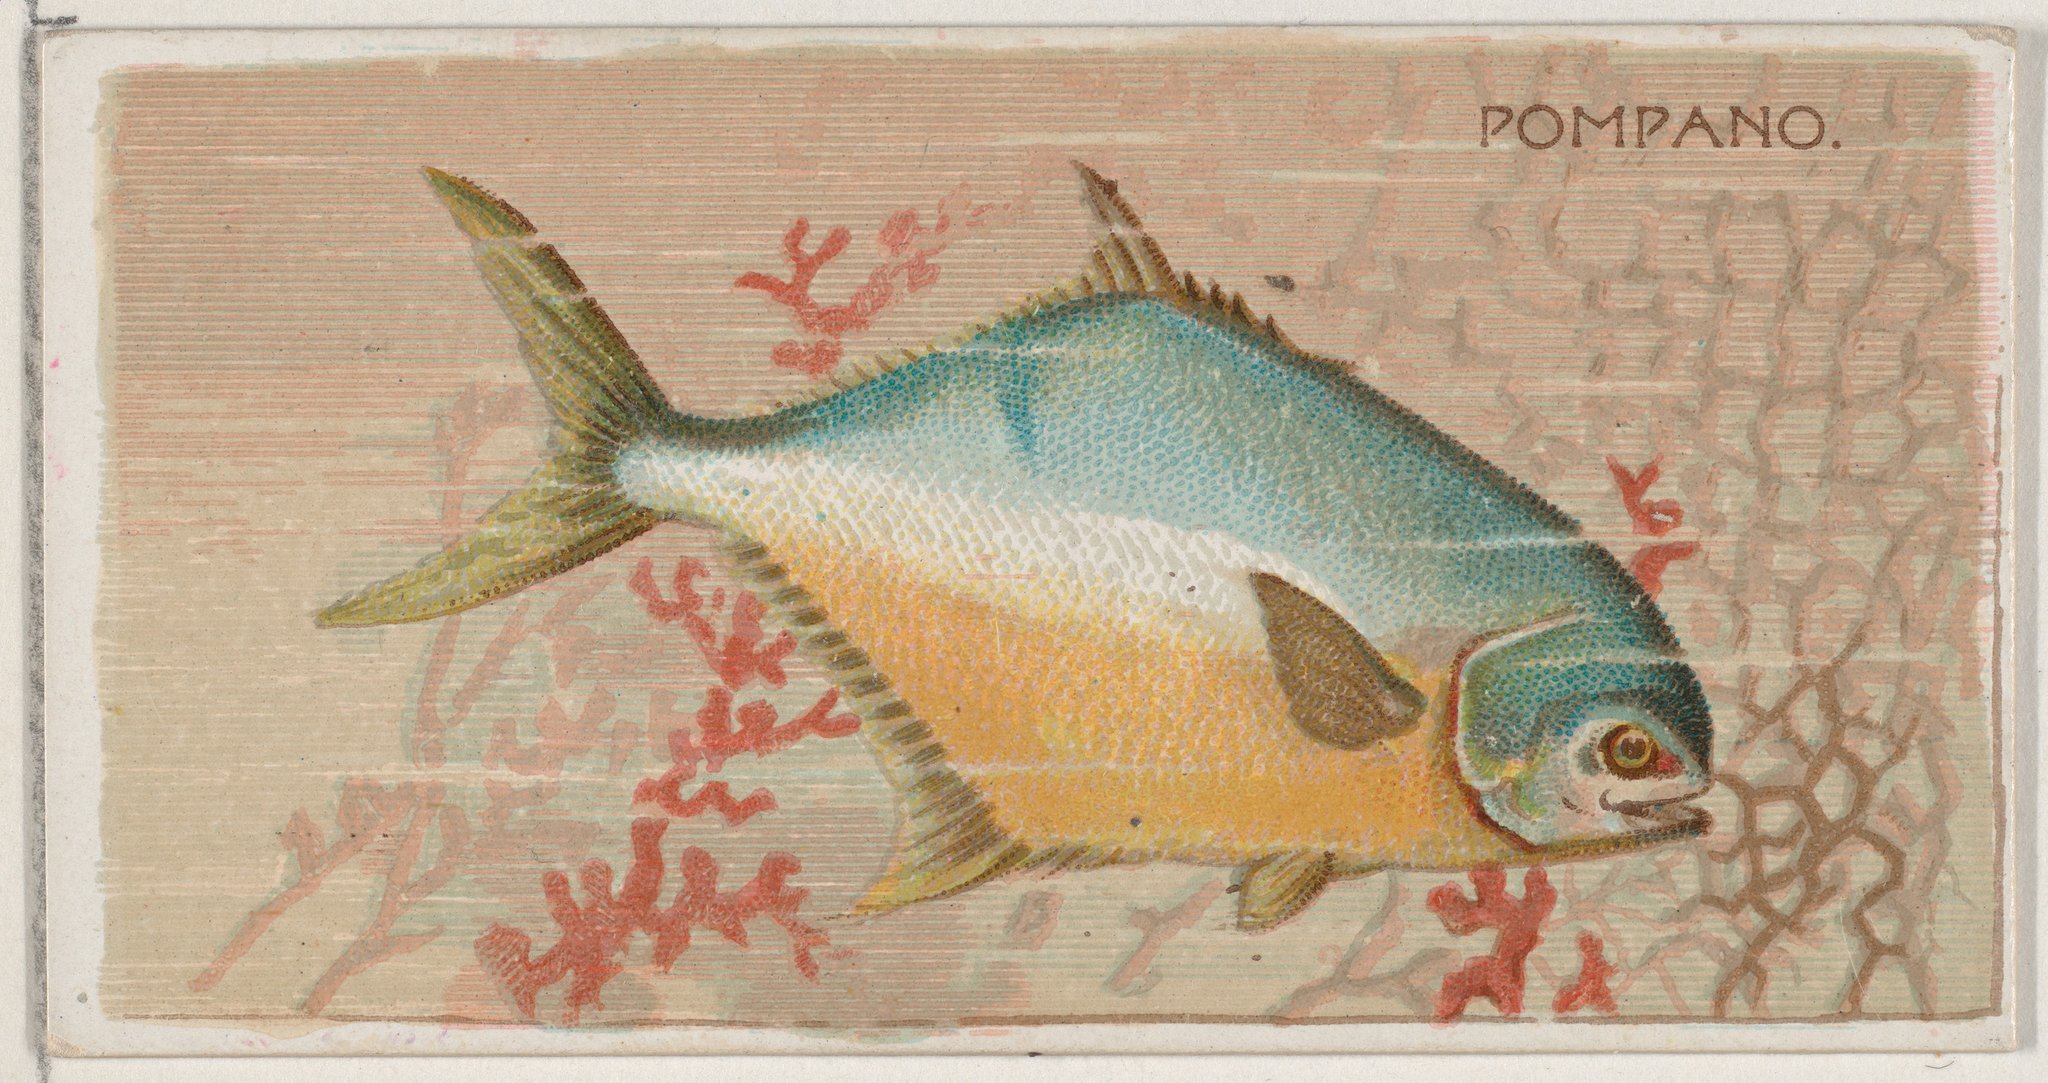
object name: print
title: Pompano, from the series Fishers and Fish (N74) for Duke brand cigarettes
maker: knapp & company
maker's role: lithographer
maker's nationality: american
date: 1888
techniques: color lithograph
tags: fish